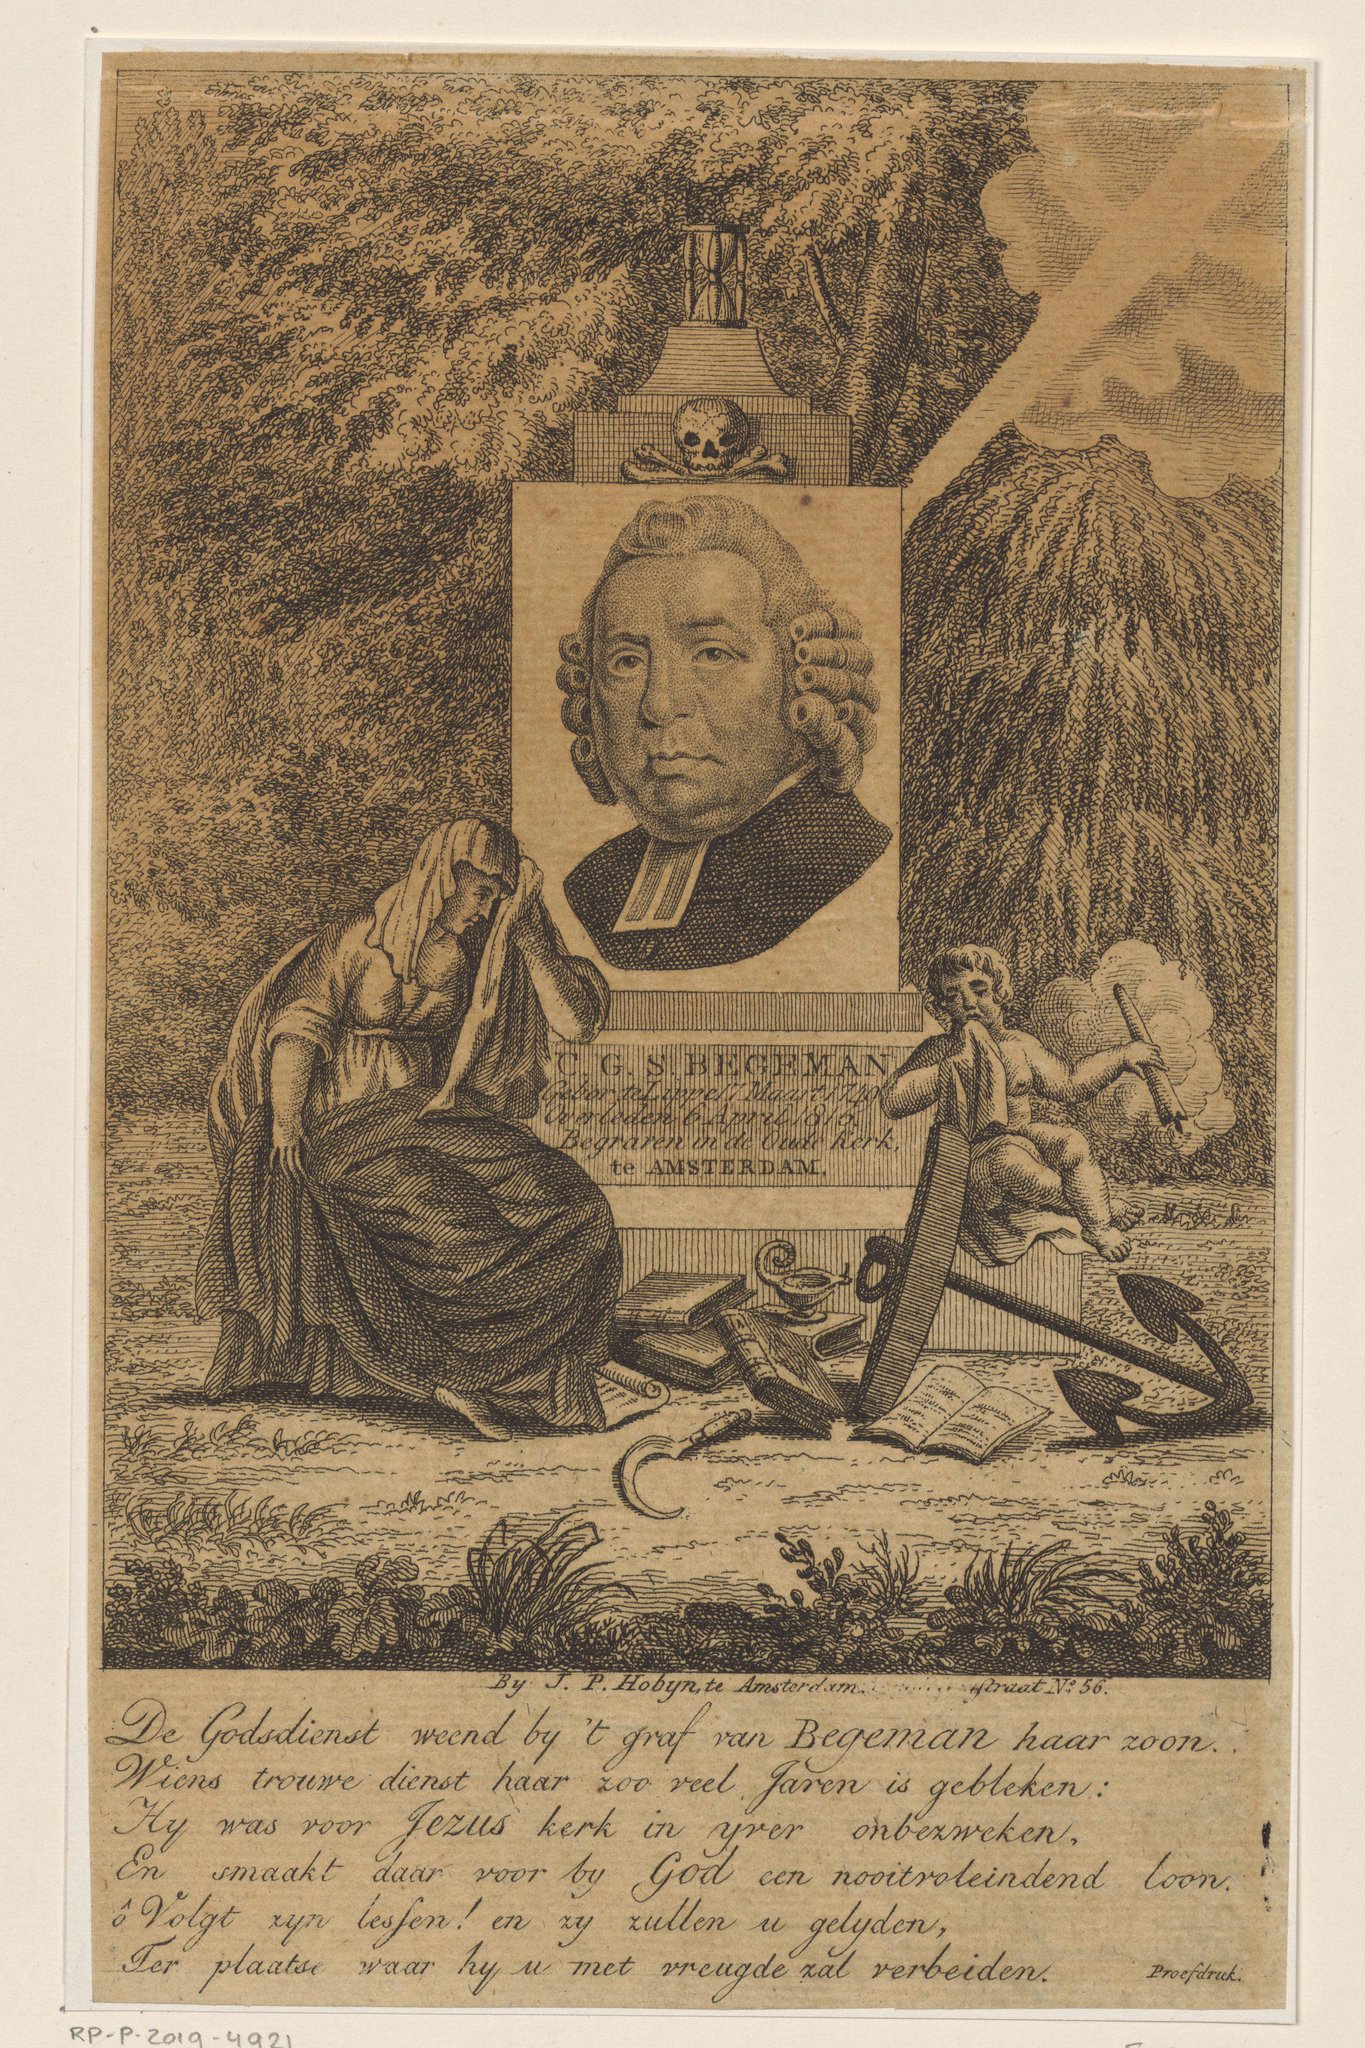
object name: print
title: Herdenkingsprent ter nagedachtenis aan Christoph Georg Siegmund Begemann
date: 1816-1818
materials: paper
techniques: etching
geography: amsterdam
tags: amsterdam, historical persons, grave, tomb, book, mourning customs, parts of ship's exterior: anchor